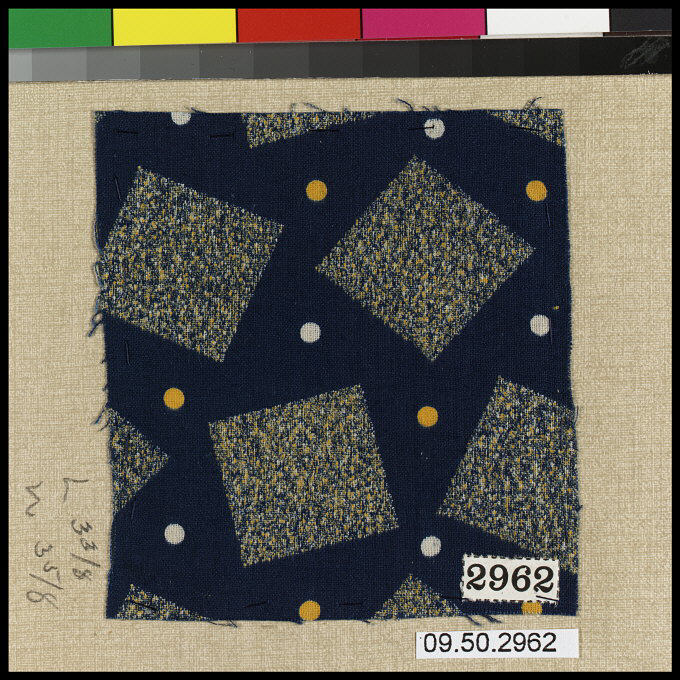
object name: piece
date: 1801-1900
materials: cotton